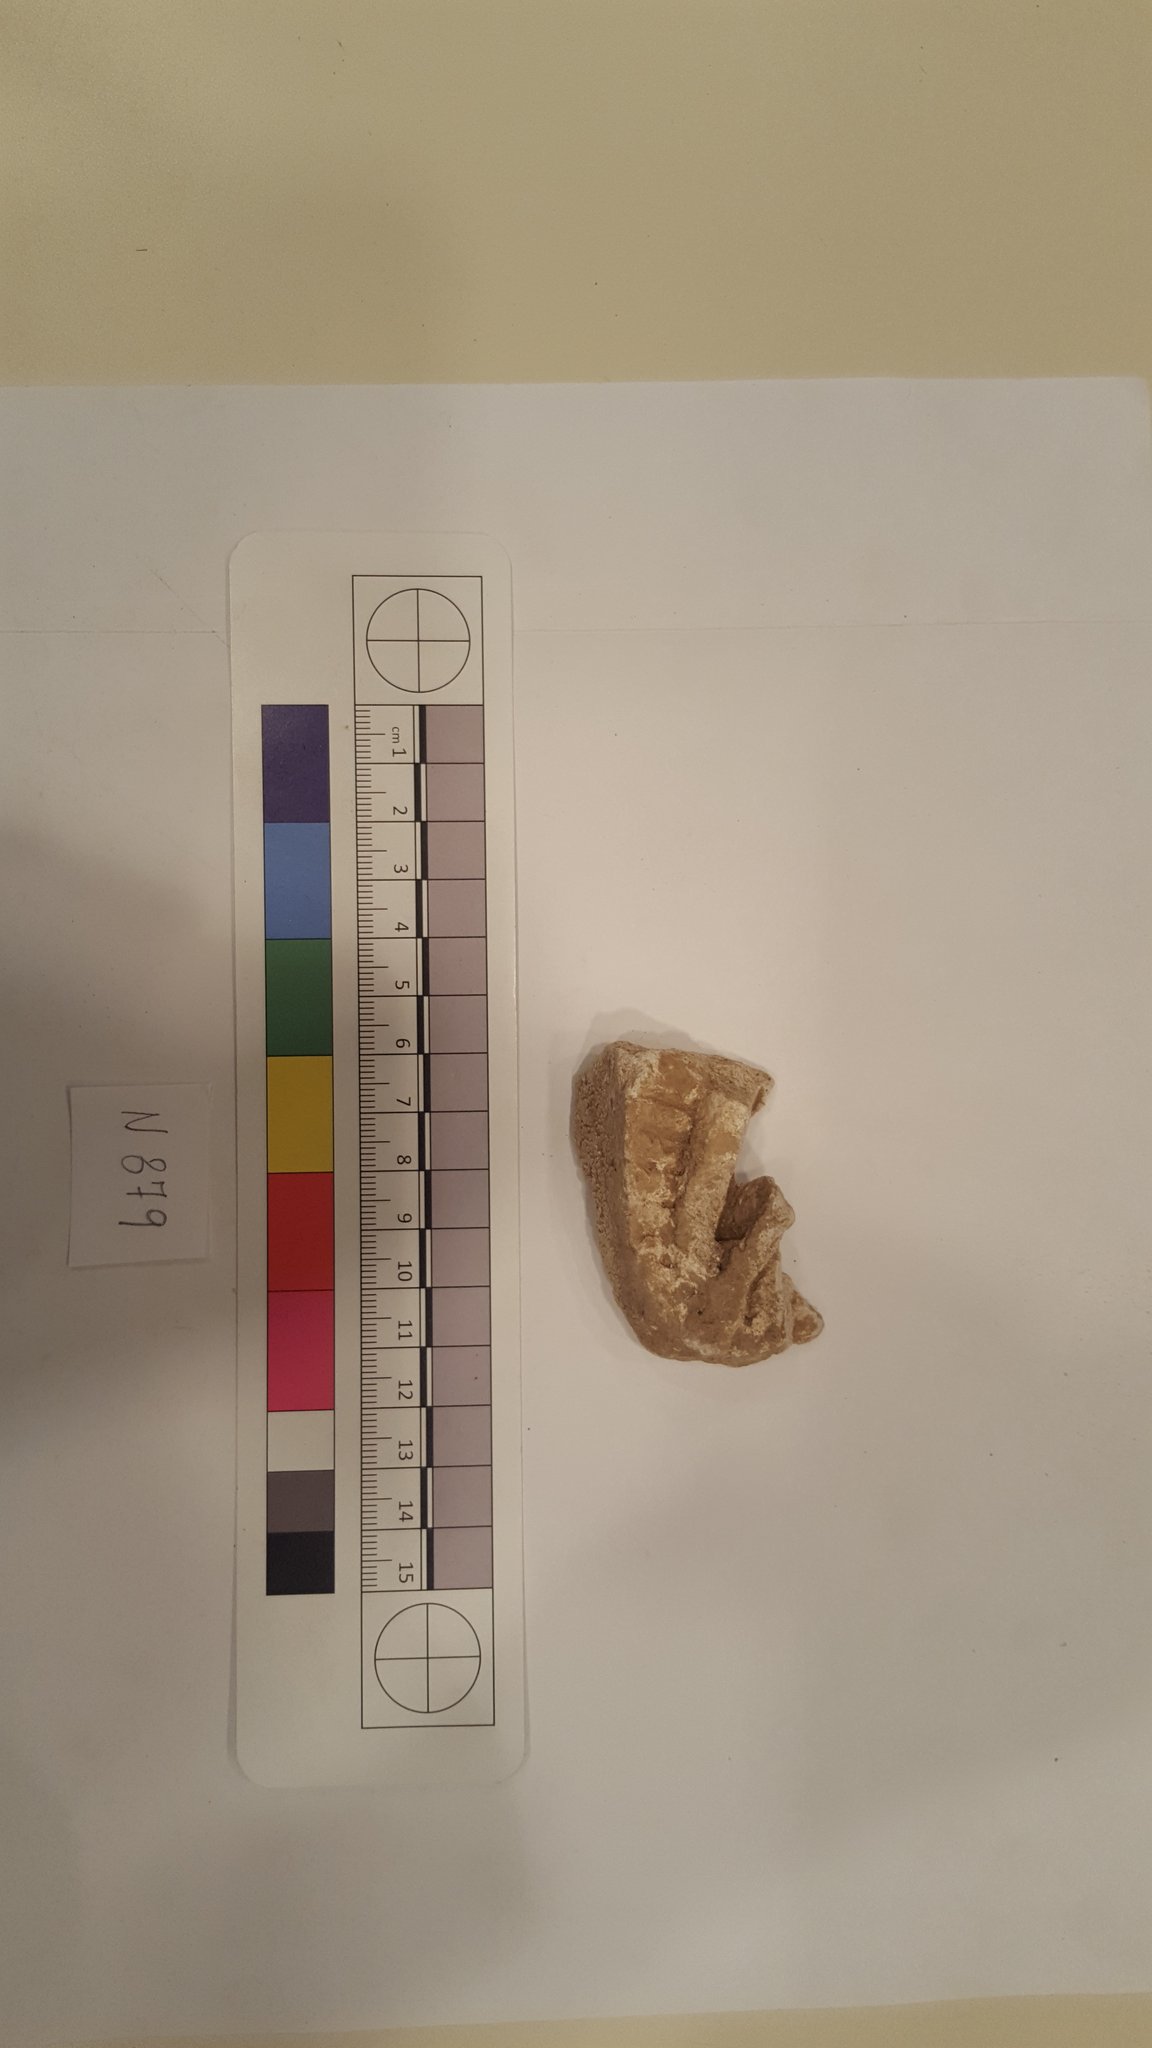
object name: fragment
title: Stucco Fragment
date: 701-1200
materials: plaster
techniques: carving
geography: iran